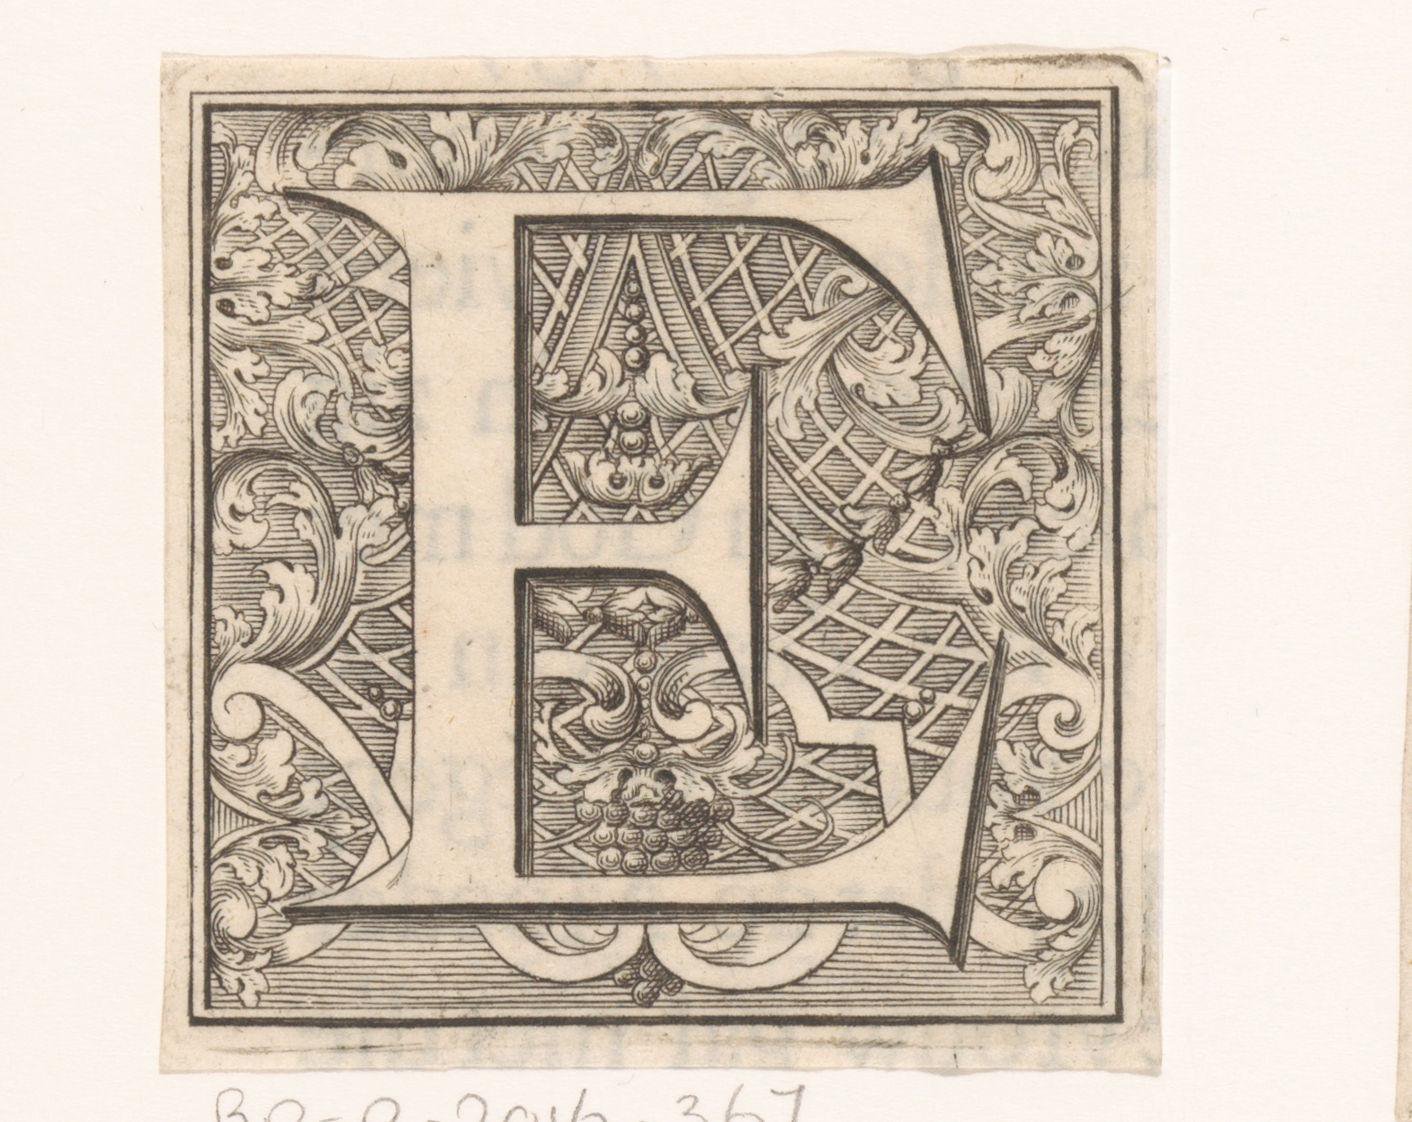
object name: ornament print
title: Letter E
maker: Anonymous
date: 1700-1799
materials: paper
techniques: etching, letterpress printing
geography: netherlands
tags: fancy letters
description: Letter E tegen een achtergrond met vlechtwerk.